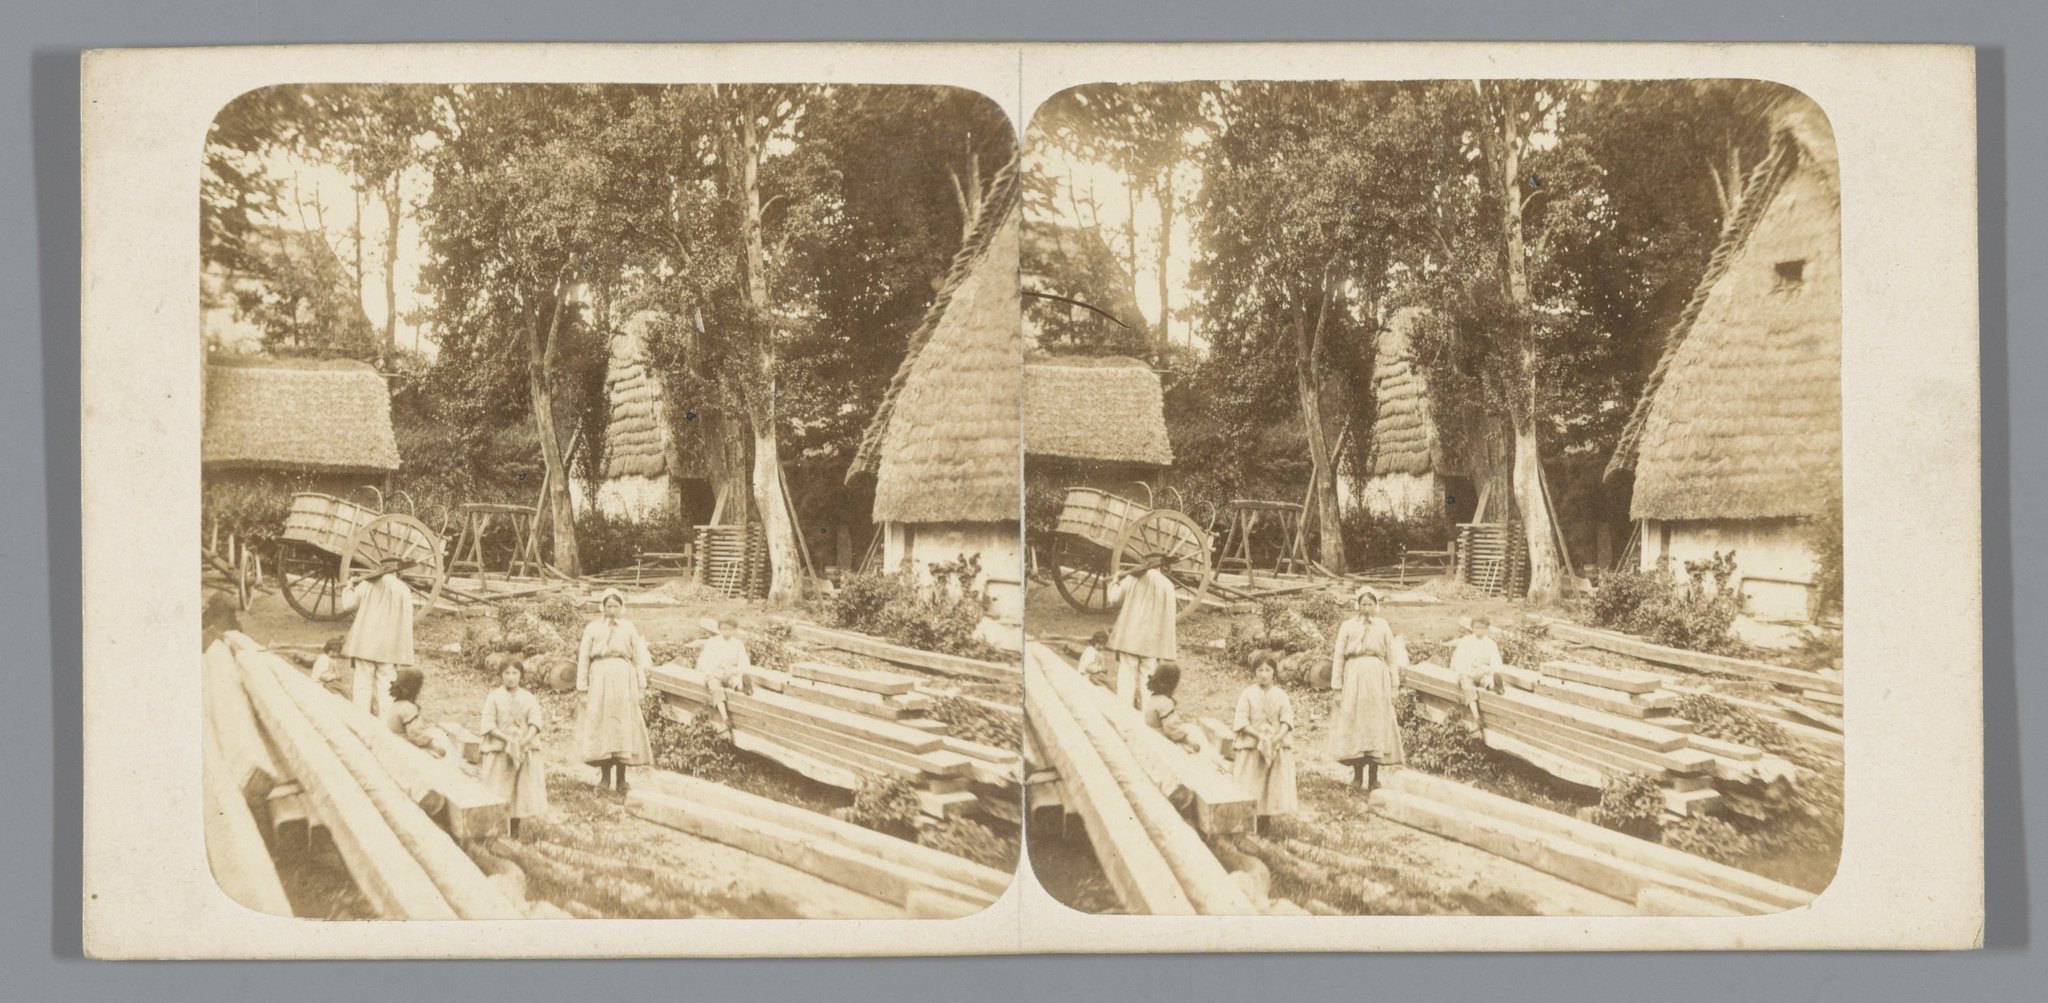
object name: stereograph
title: Hakgebied te Normandië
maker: Anonymous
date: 1860-1880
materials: cardboard, photographic support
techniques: albumen print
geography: normandy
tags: timber yard, lumber stack, historical persons not known by name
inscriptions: inscription: ‘Chantier de bois, Normandie’, number: ‘44’